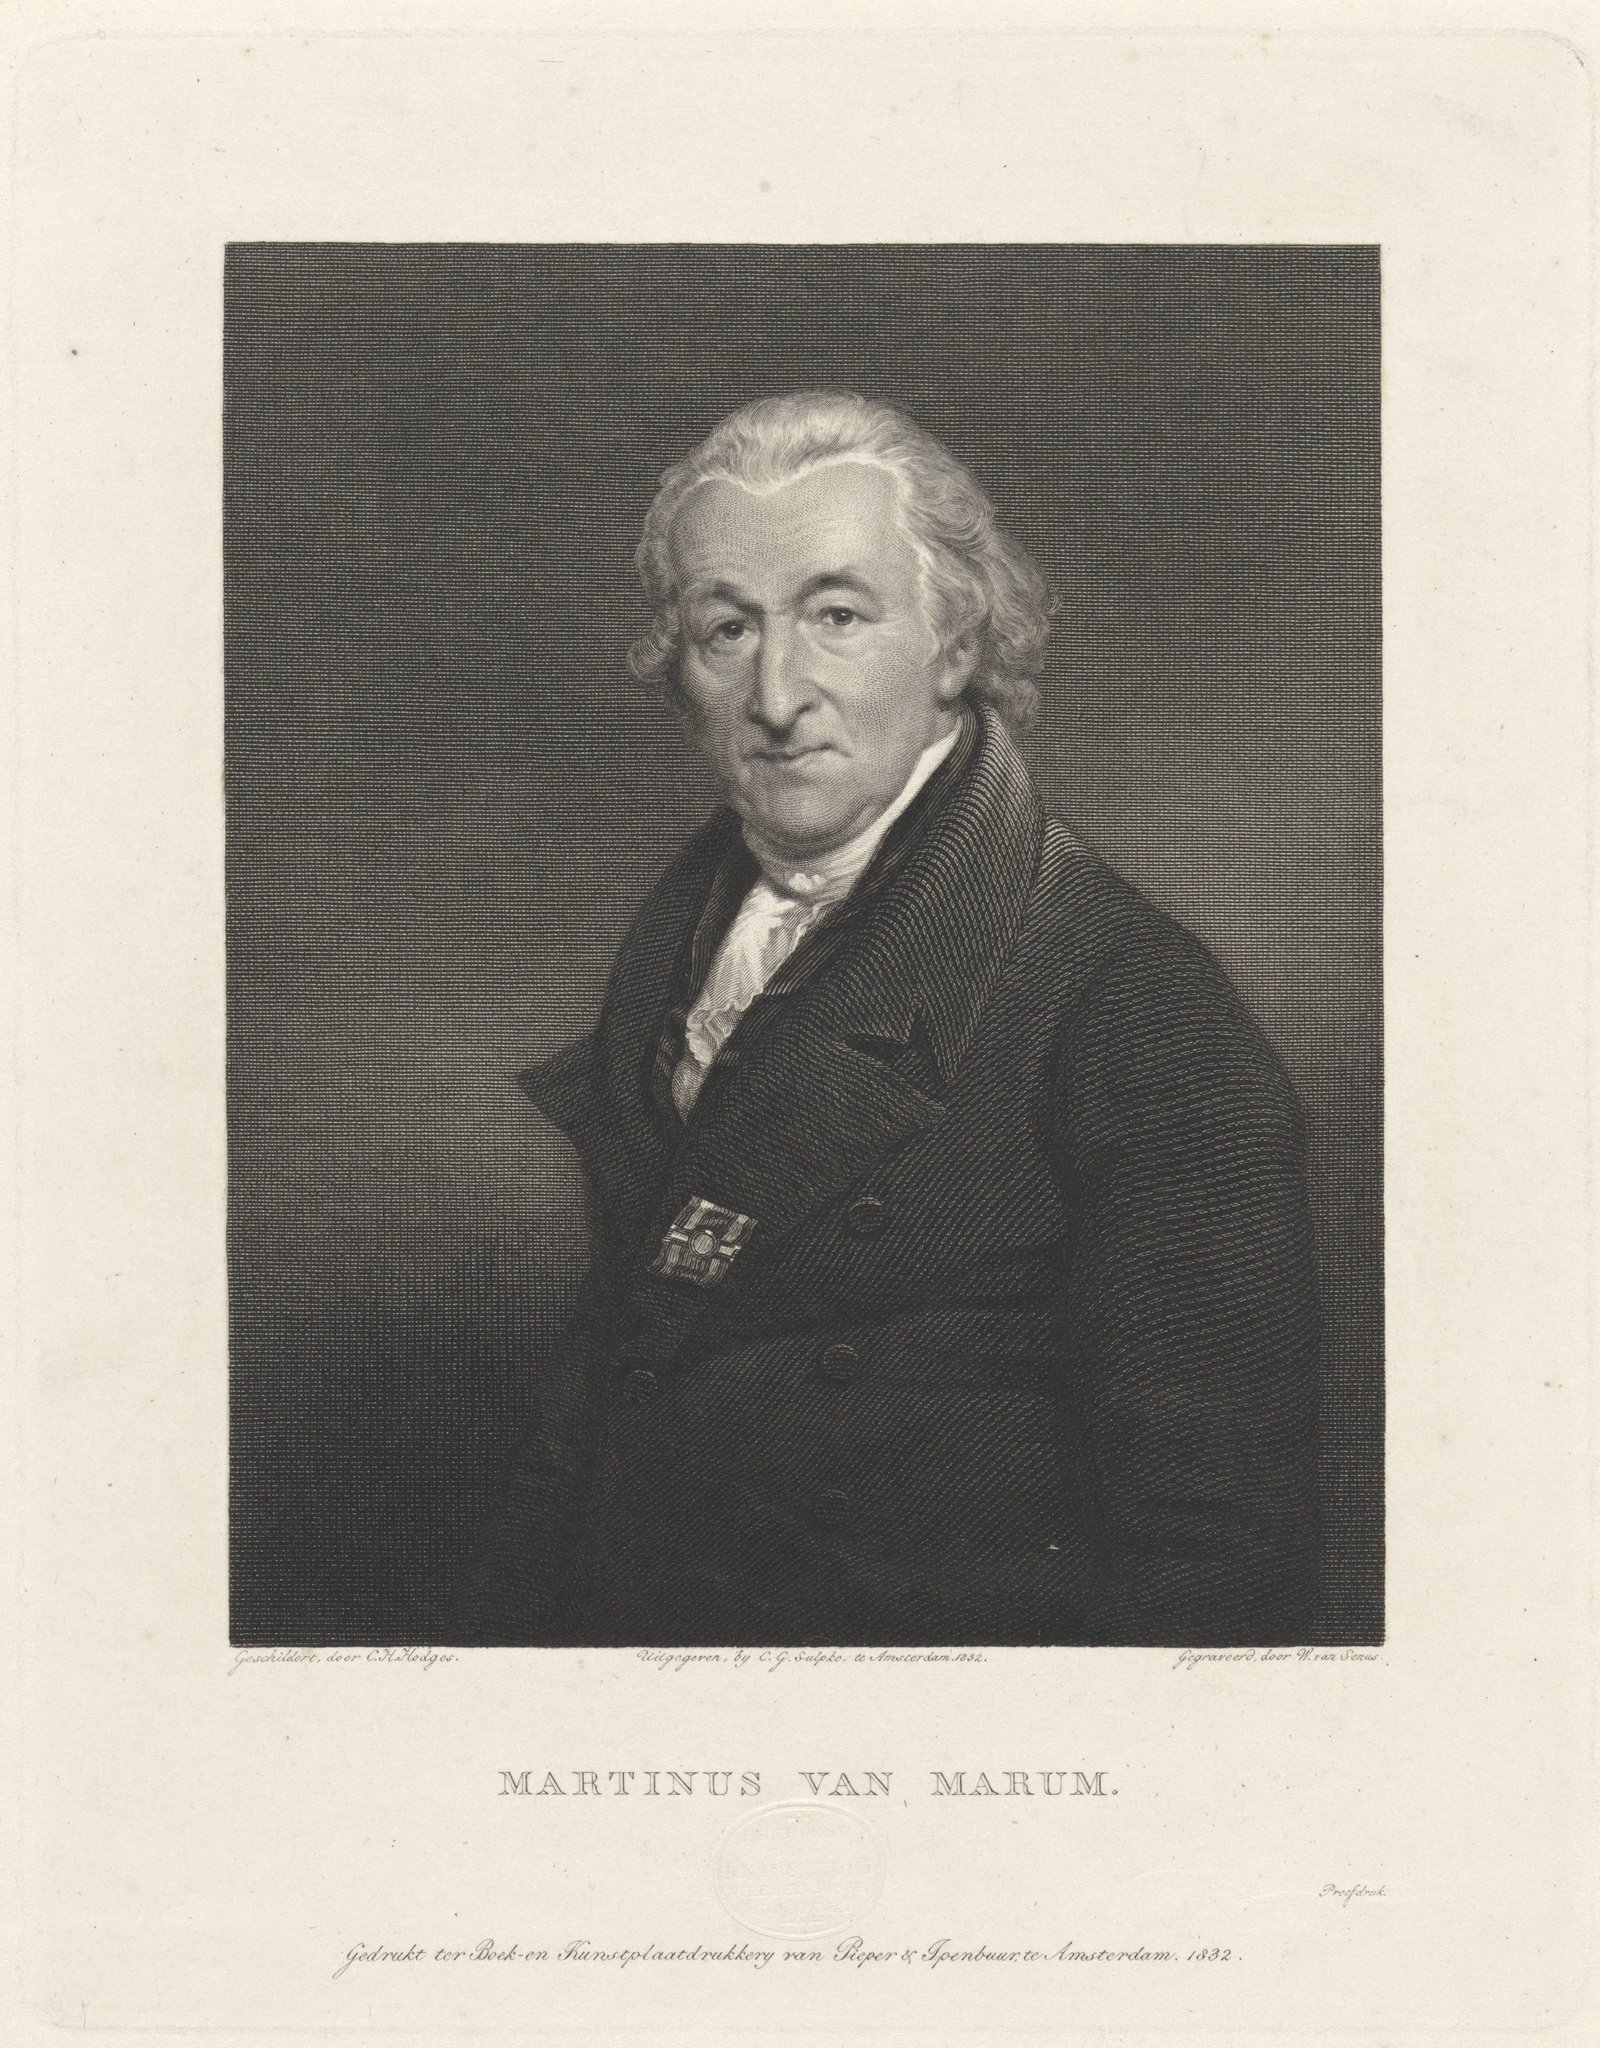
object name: print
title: Portret van Martinus van Marum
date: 1832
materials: paper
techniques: engraving, etching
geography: amsterdam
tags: physicist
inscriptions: collector's mark: Lugt 2228, stamp: ‘Bekroond door KN instituut vierde classe MDCCCXXXI’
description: Portret van de schei- en natuurkundige Martinus van Marum.